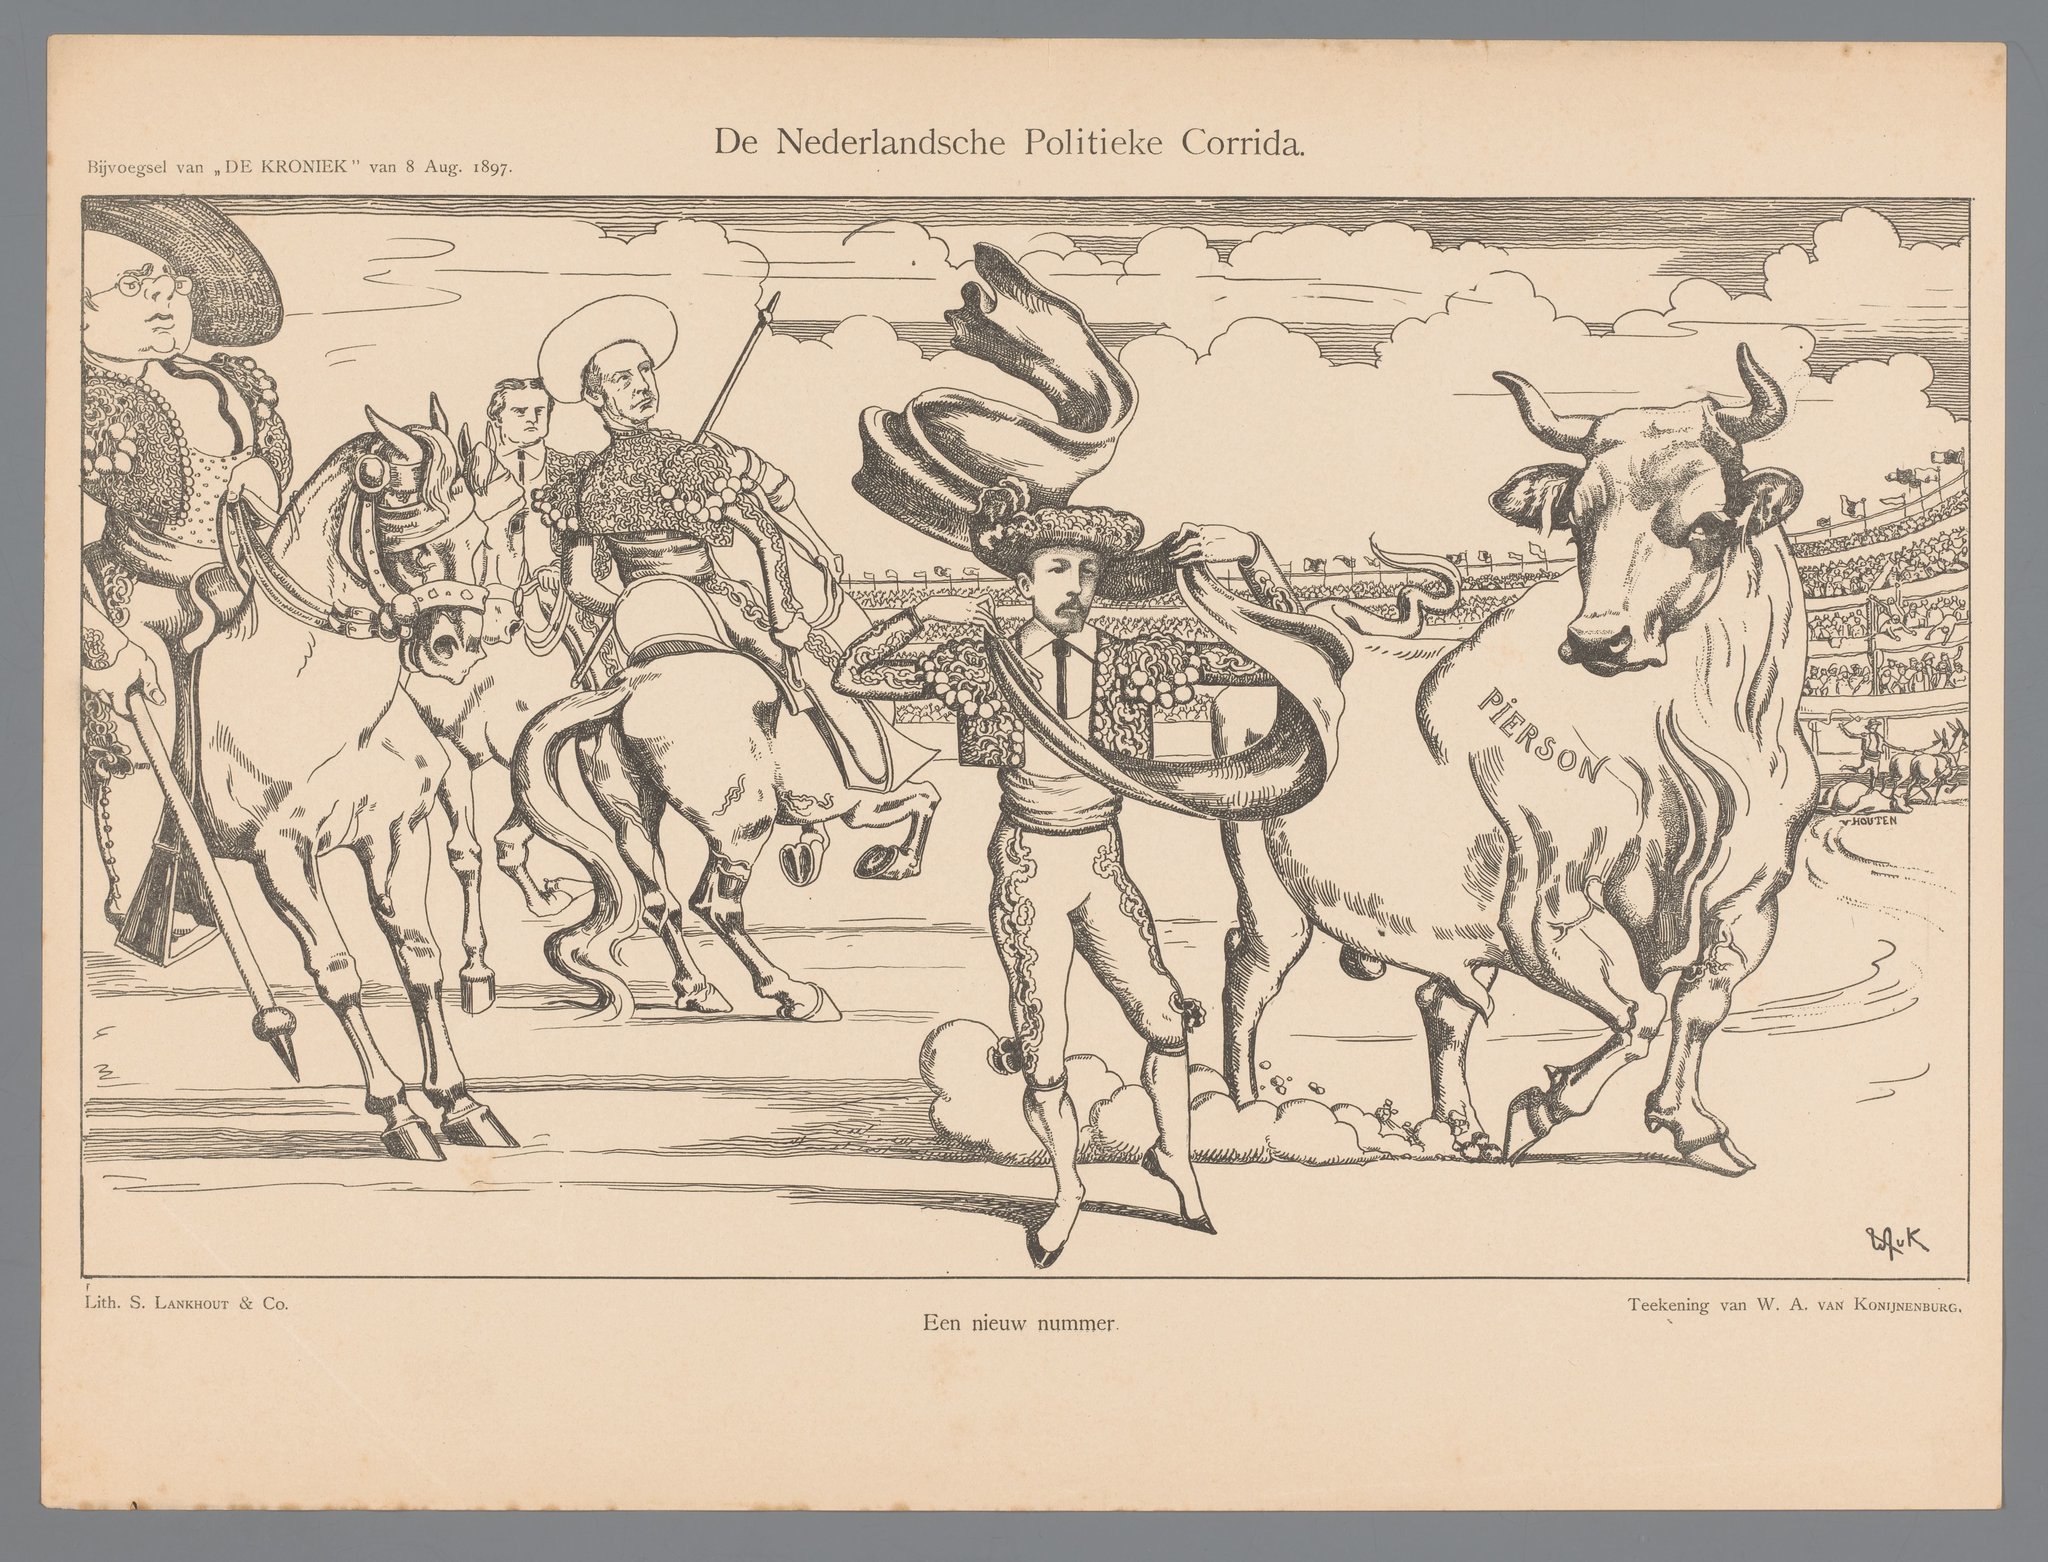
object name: cartoon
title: De Nederlandsche politieke corrida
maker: willem van konijnenburg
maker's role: draughtsman, painter, print maker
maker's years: 1868-1943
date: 1897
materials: paper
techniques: lithograph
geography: the hague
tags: amsterdam, politician, nicolaas gerard pierson, bullfight, bull-fighter, toreador, political caricatures and satires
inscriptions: date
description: Prent uit het bijvoegsel van: De Kroniek 3 (1897), 8 augustus 1897.